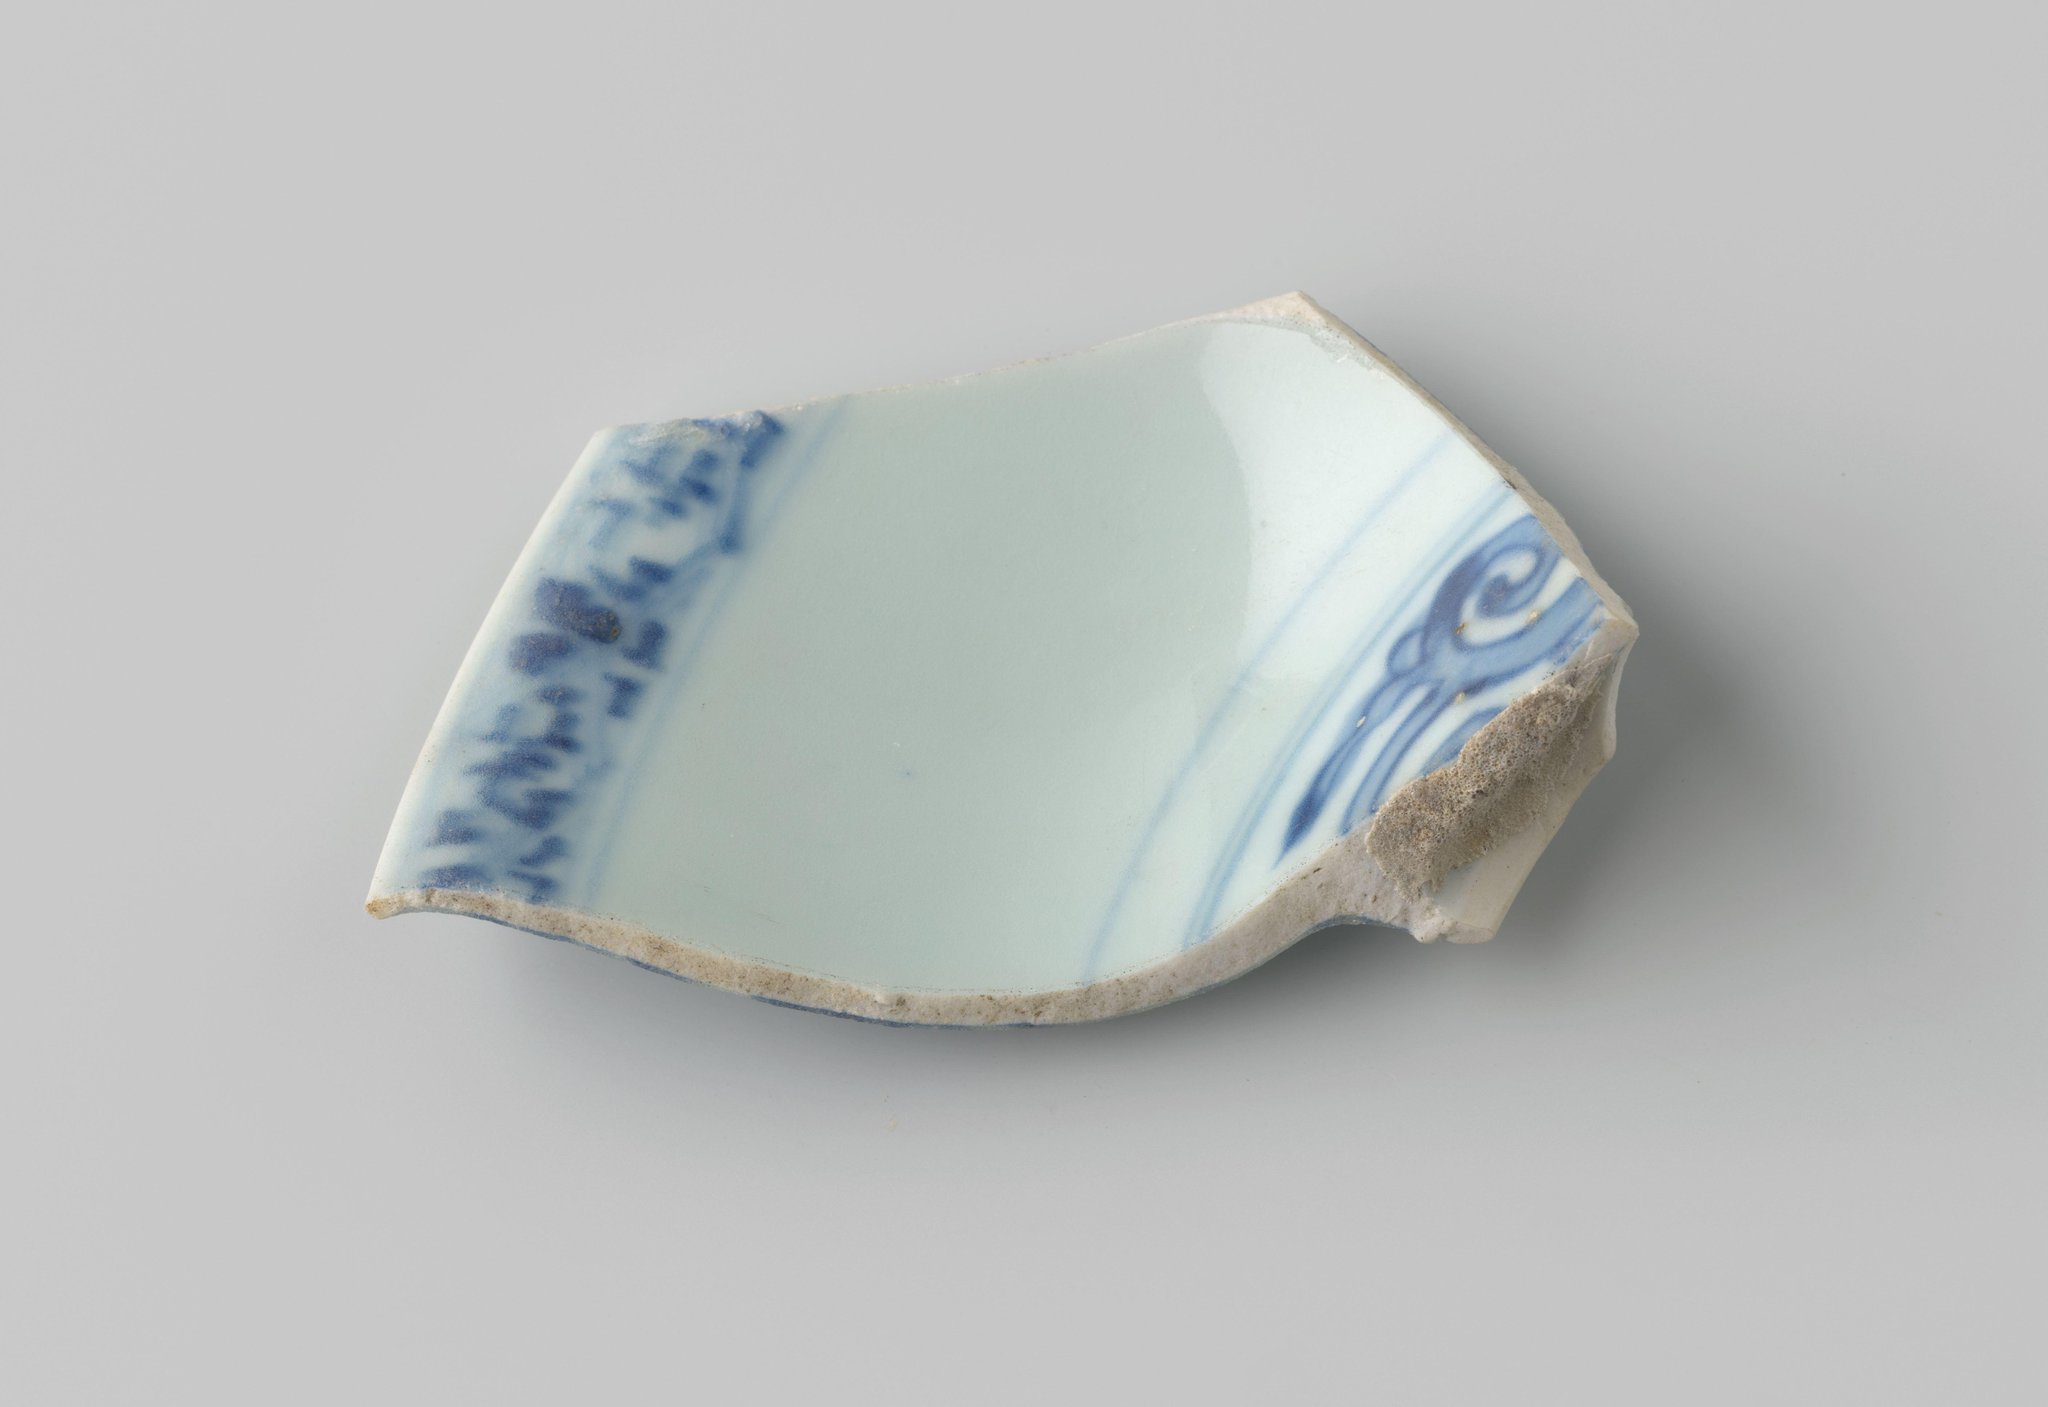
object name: bowl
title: Fragment kom uit V.O.C.-schip de 'Witte Leeuw'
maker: Anonymous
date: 1613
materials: porcelain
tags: verenigde oostindische compagnie, sint-helena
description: Fragment kom uit V.O.C.-schip de 'Witte Leeuw'.